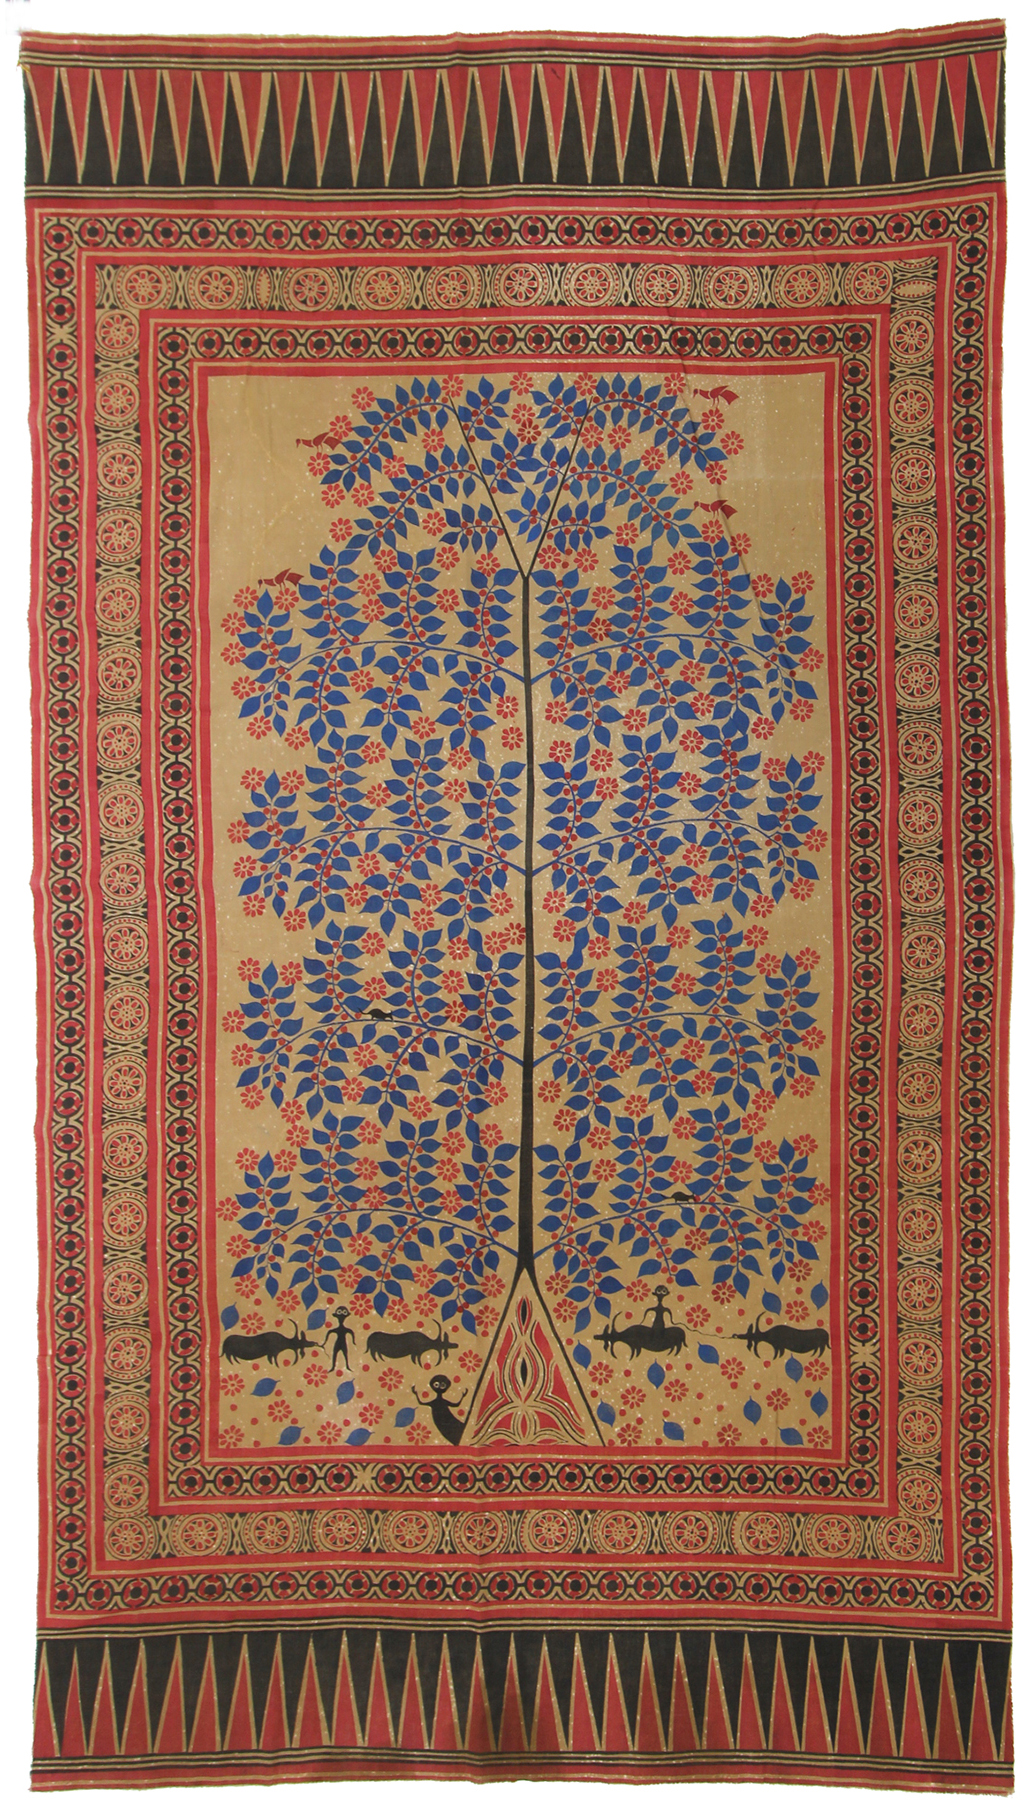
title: Maa cloth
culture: indonesian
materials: cotton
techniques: printing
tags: trees